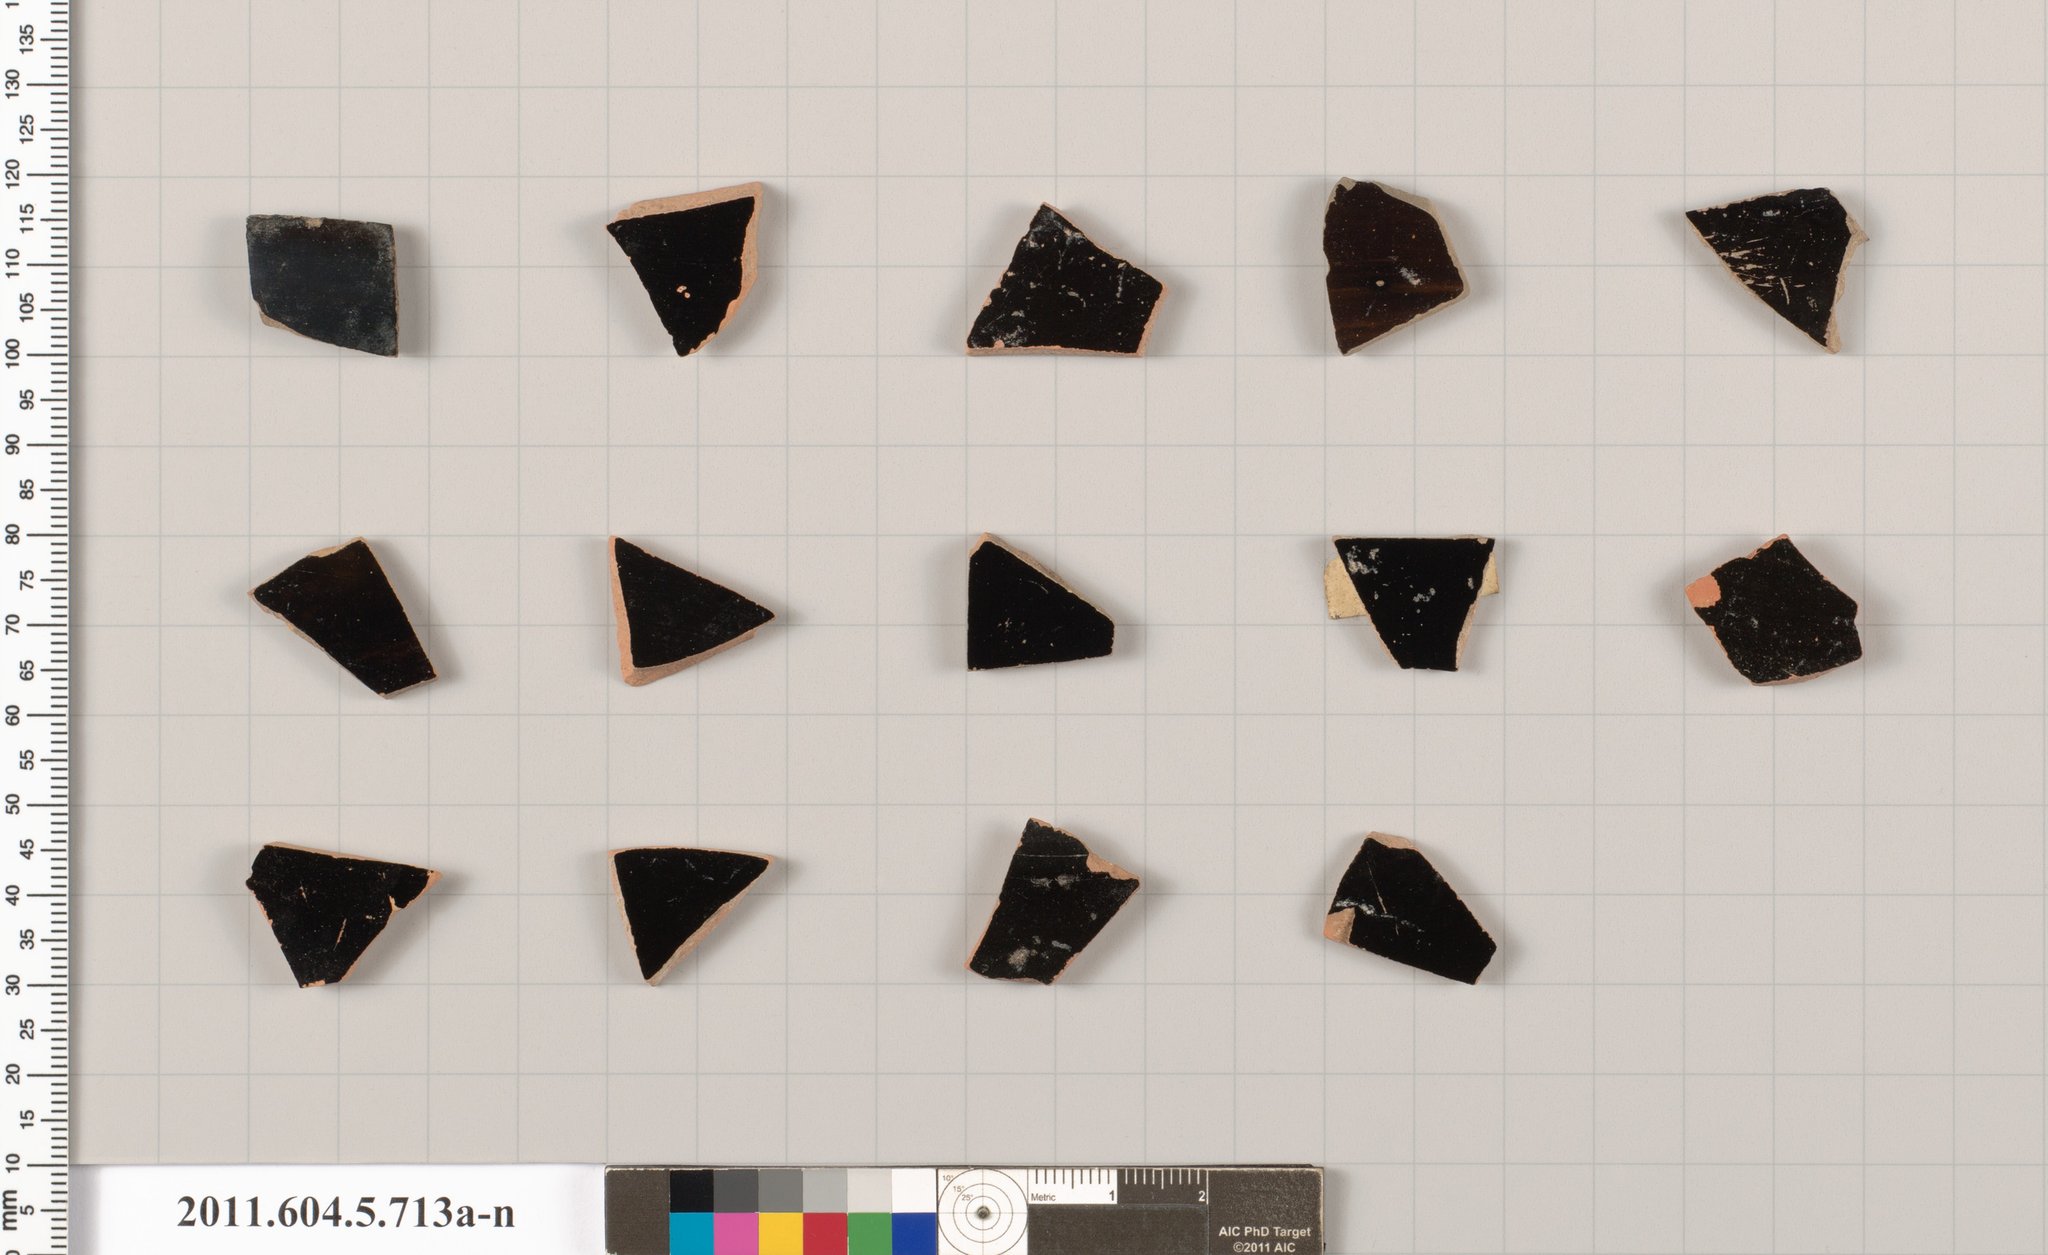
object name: kylix fragment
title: Terracotta fragments of kylikes (drinking cups)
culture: greek, attic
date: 600-401 BCE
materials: terracotta